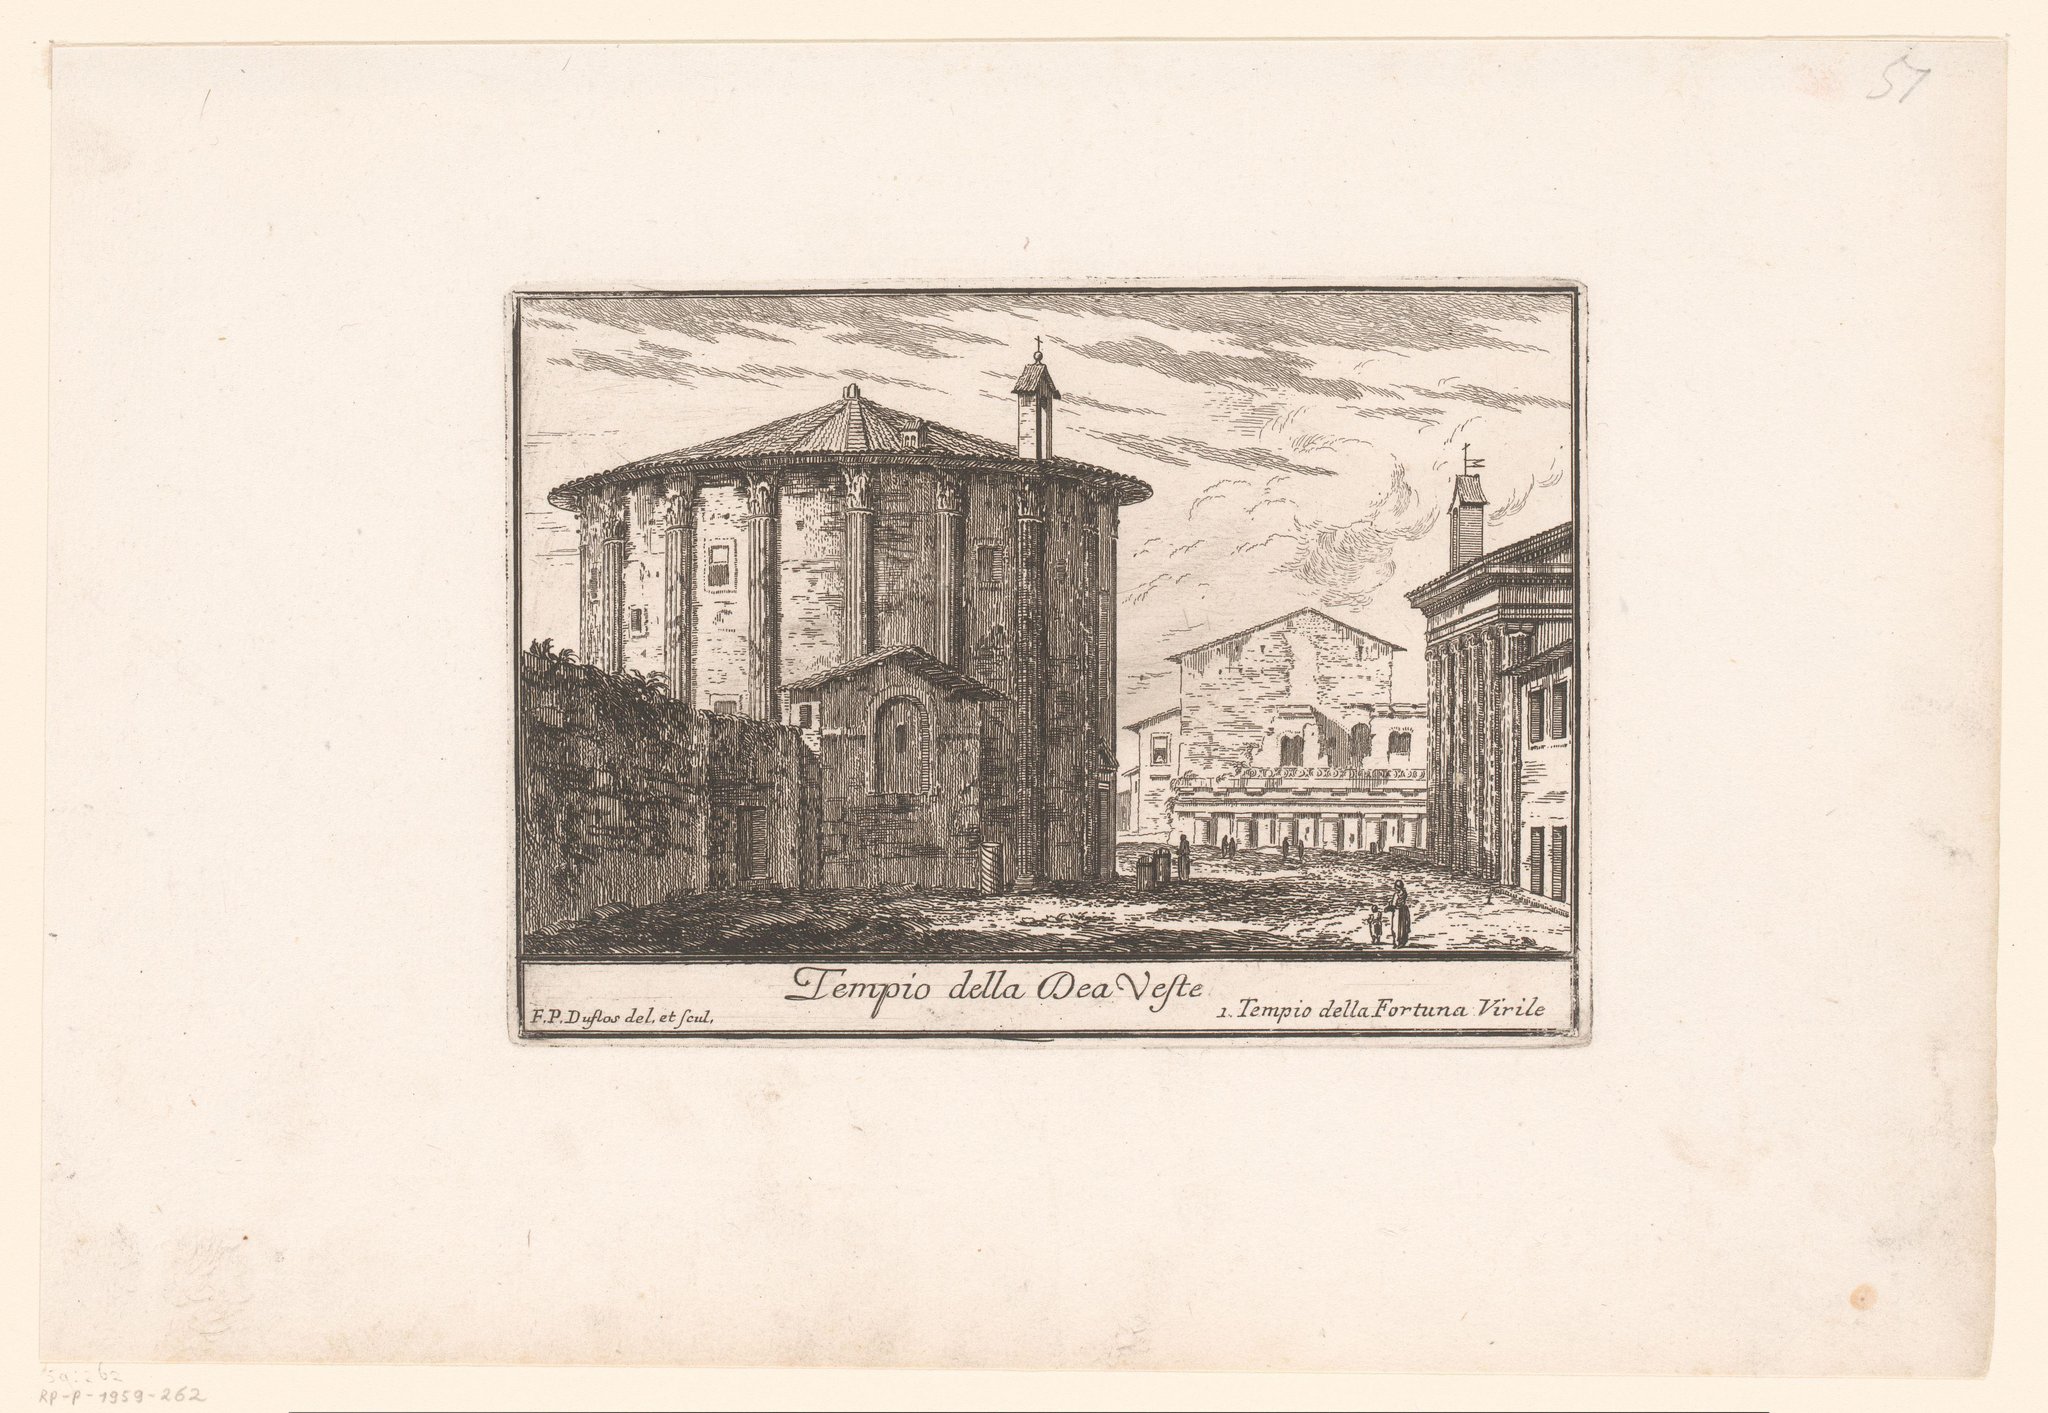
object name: print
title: Zicht op de Tempel van Vesta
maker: philothée françois duflos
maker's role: print maker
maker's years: 1710-1748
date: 1748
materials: paper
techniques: etching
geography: france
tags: city-view in general; 'veduta'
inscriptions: collector's mark: Lugt 2228, collector's mark: Lugt 2760